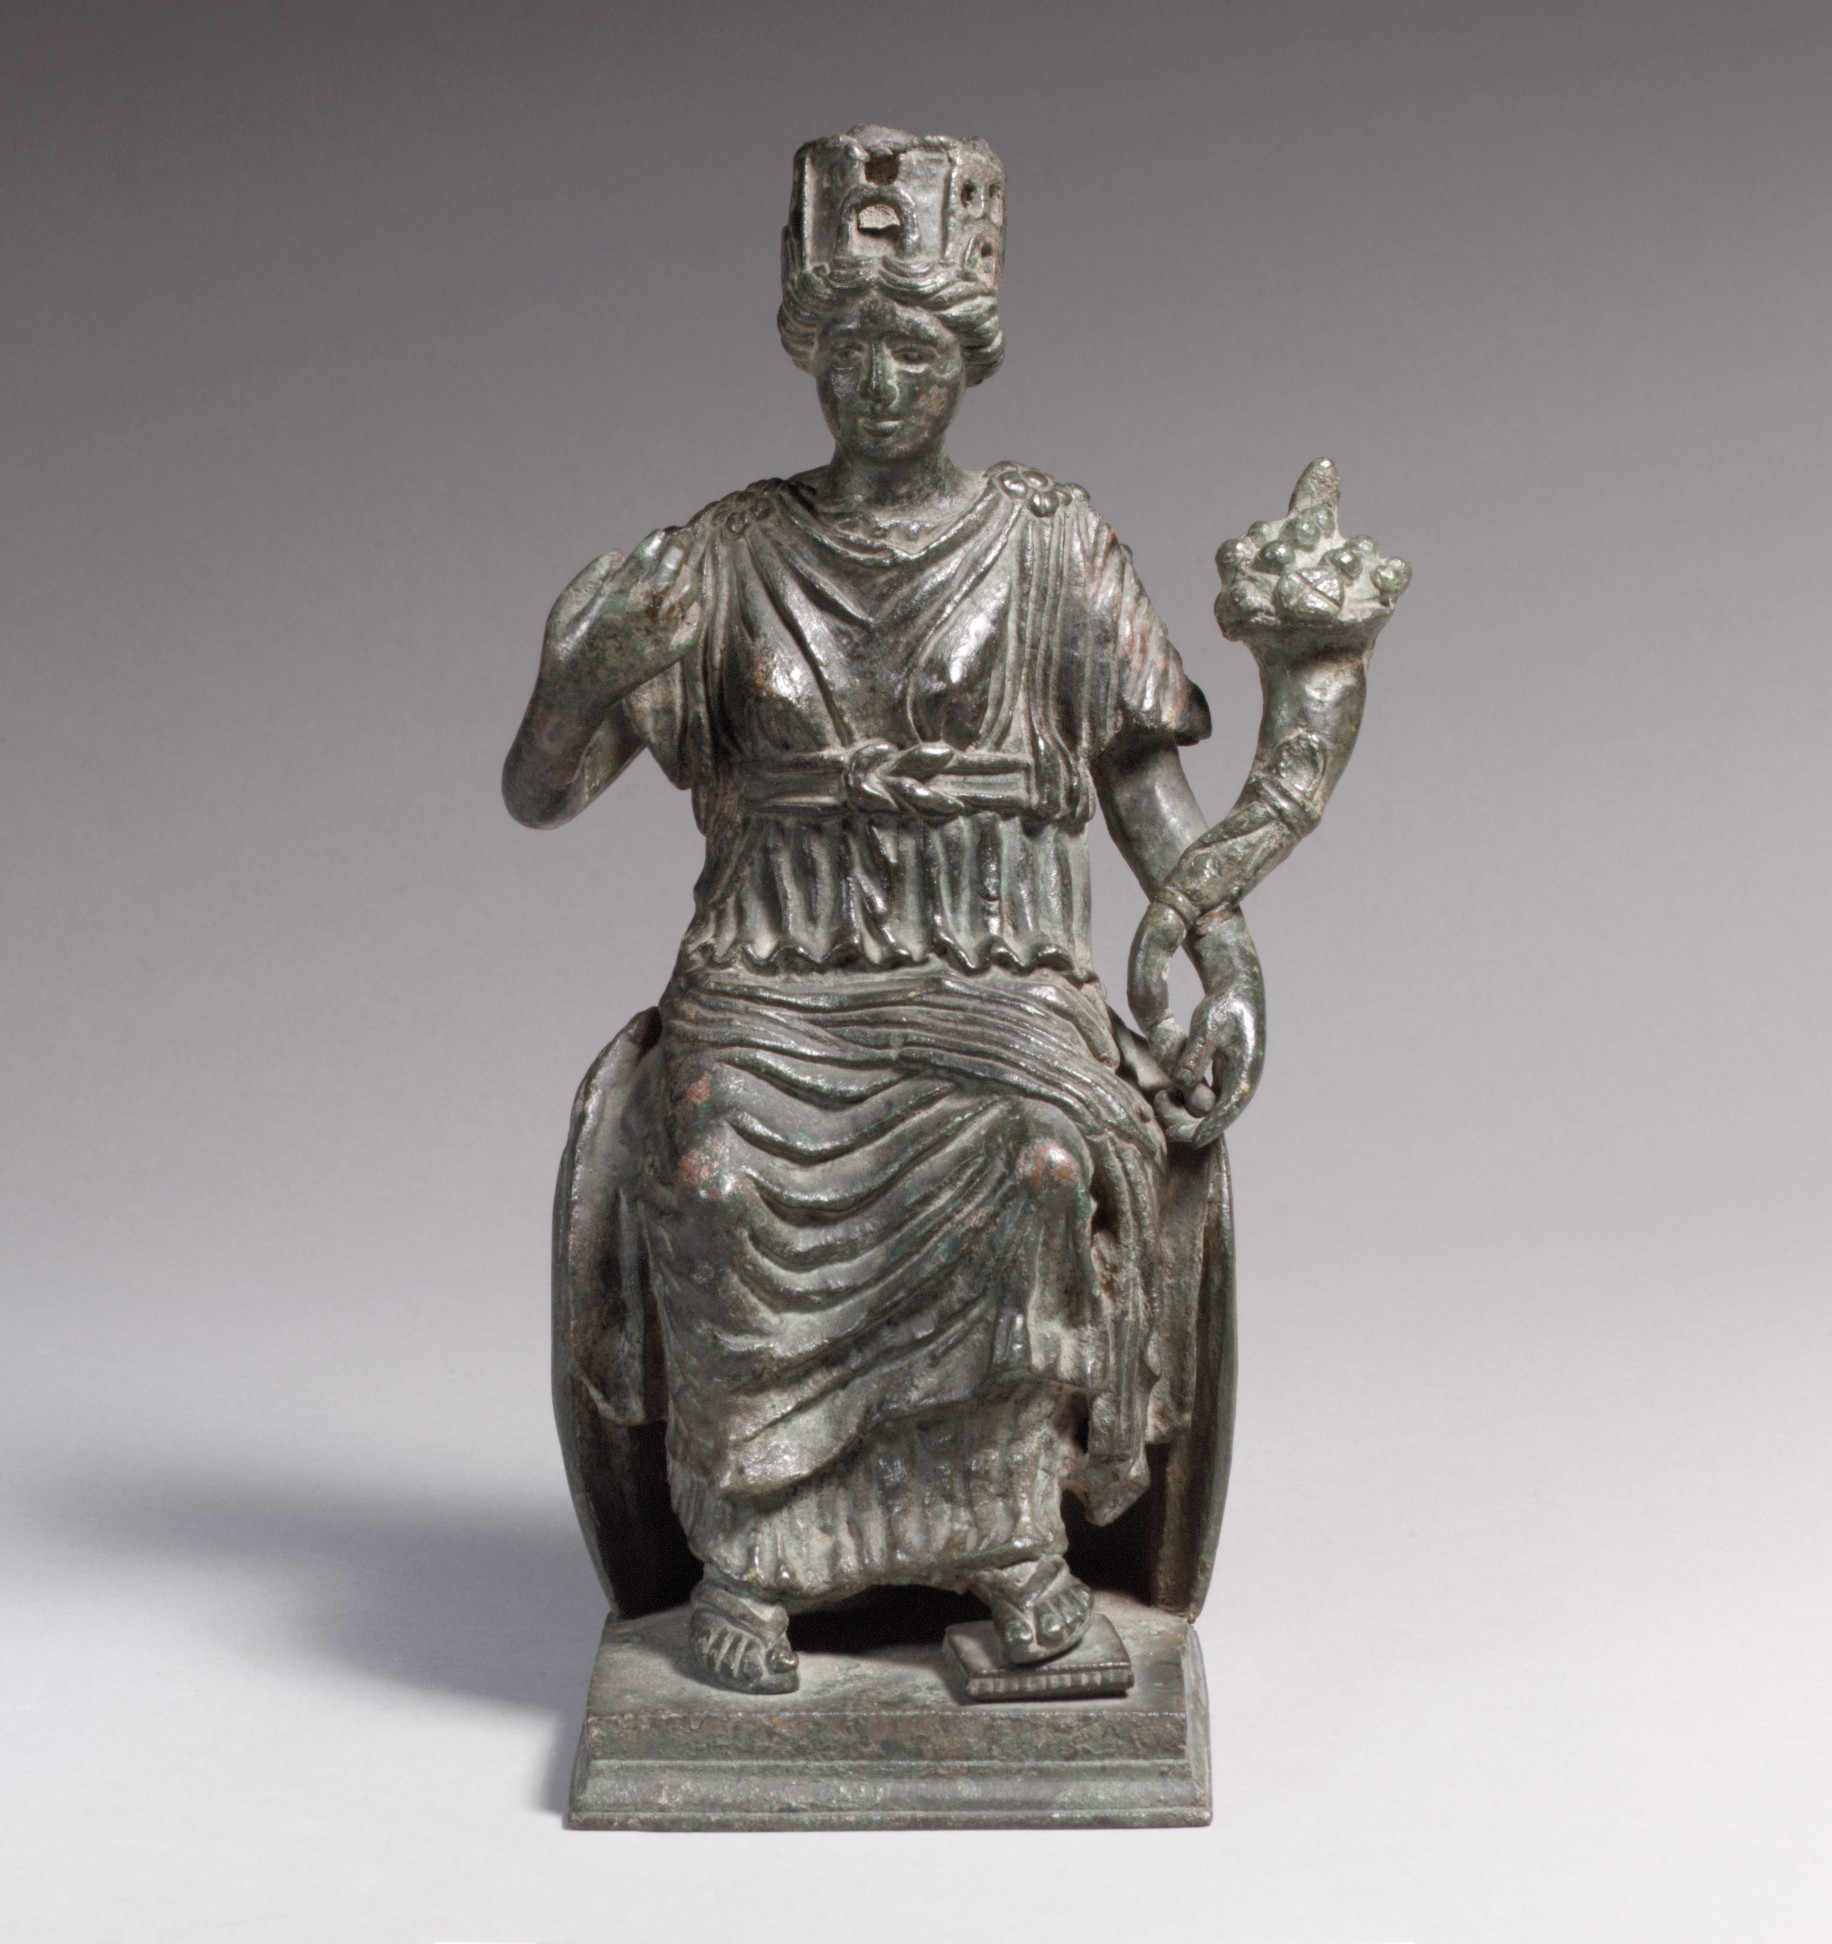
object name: statuette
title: Statuette of the Personification of a City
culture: late roman or byzantine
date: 300-500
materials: copper alloy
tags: women,cornucopia